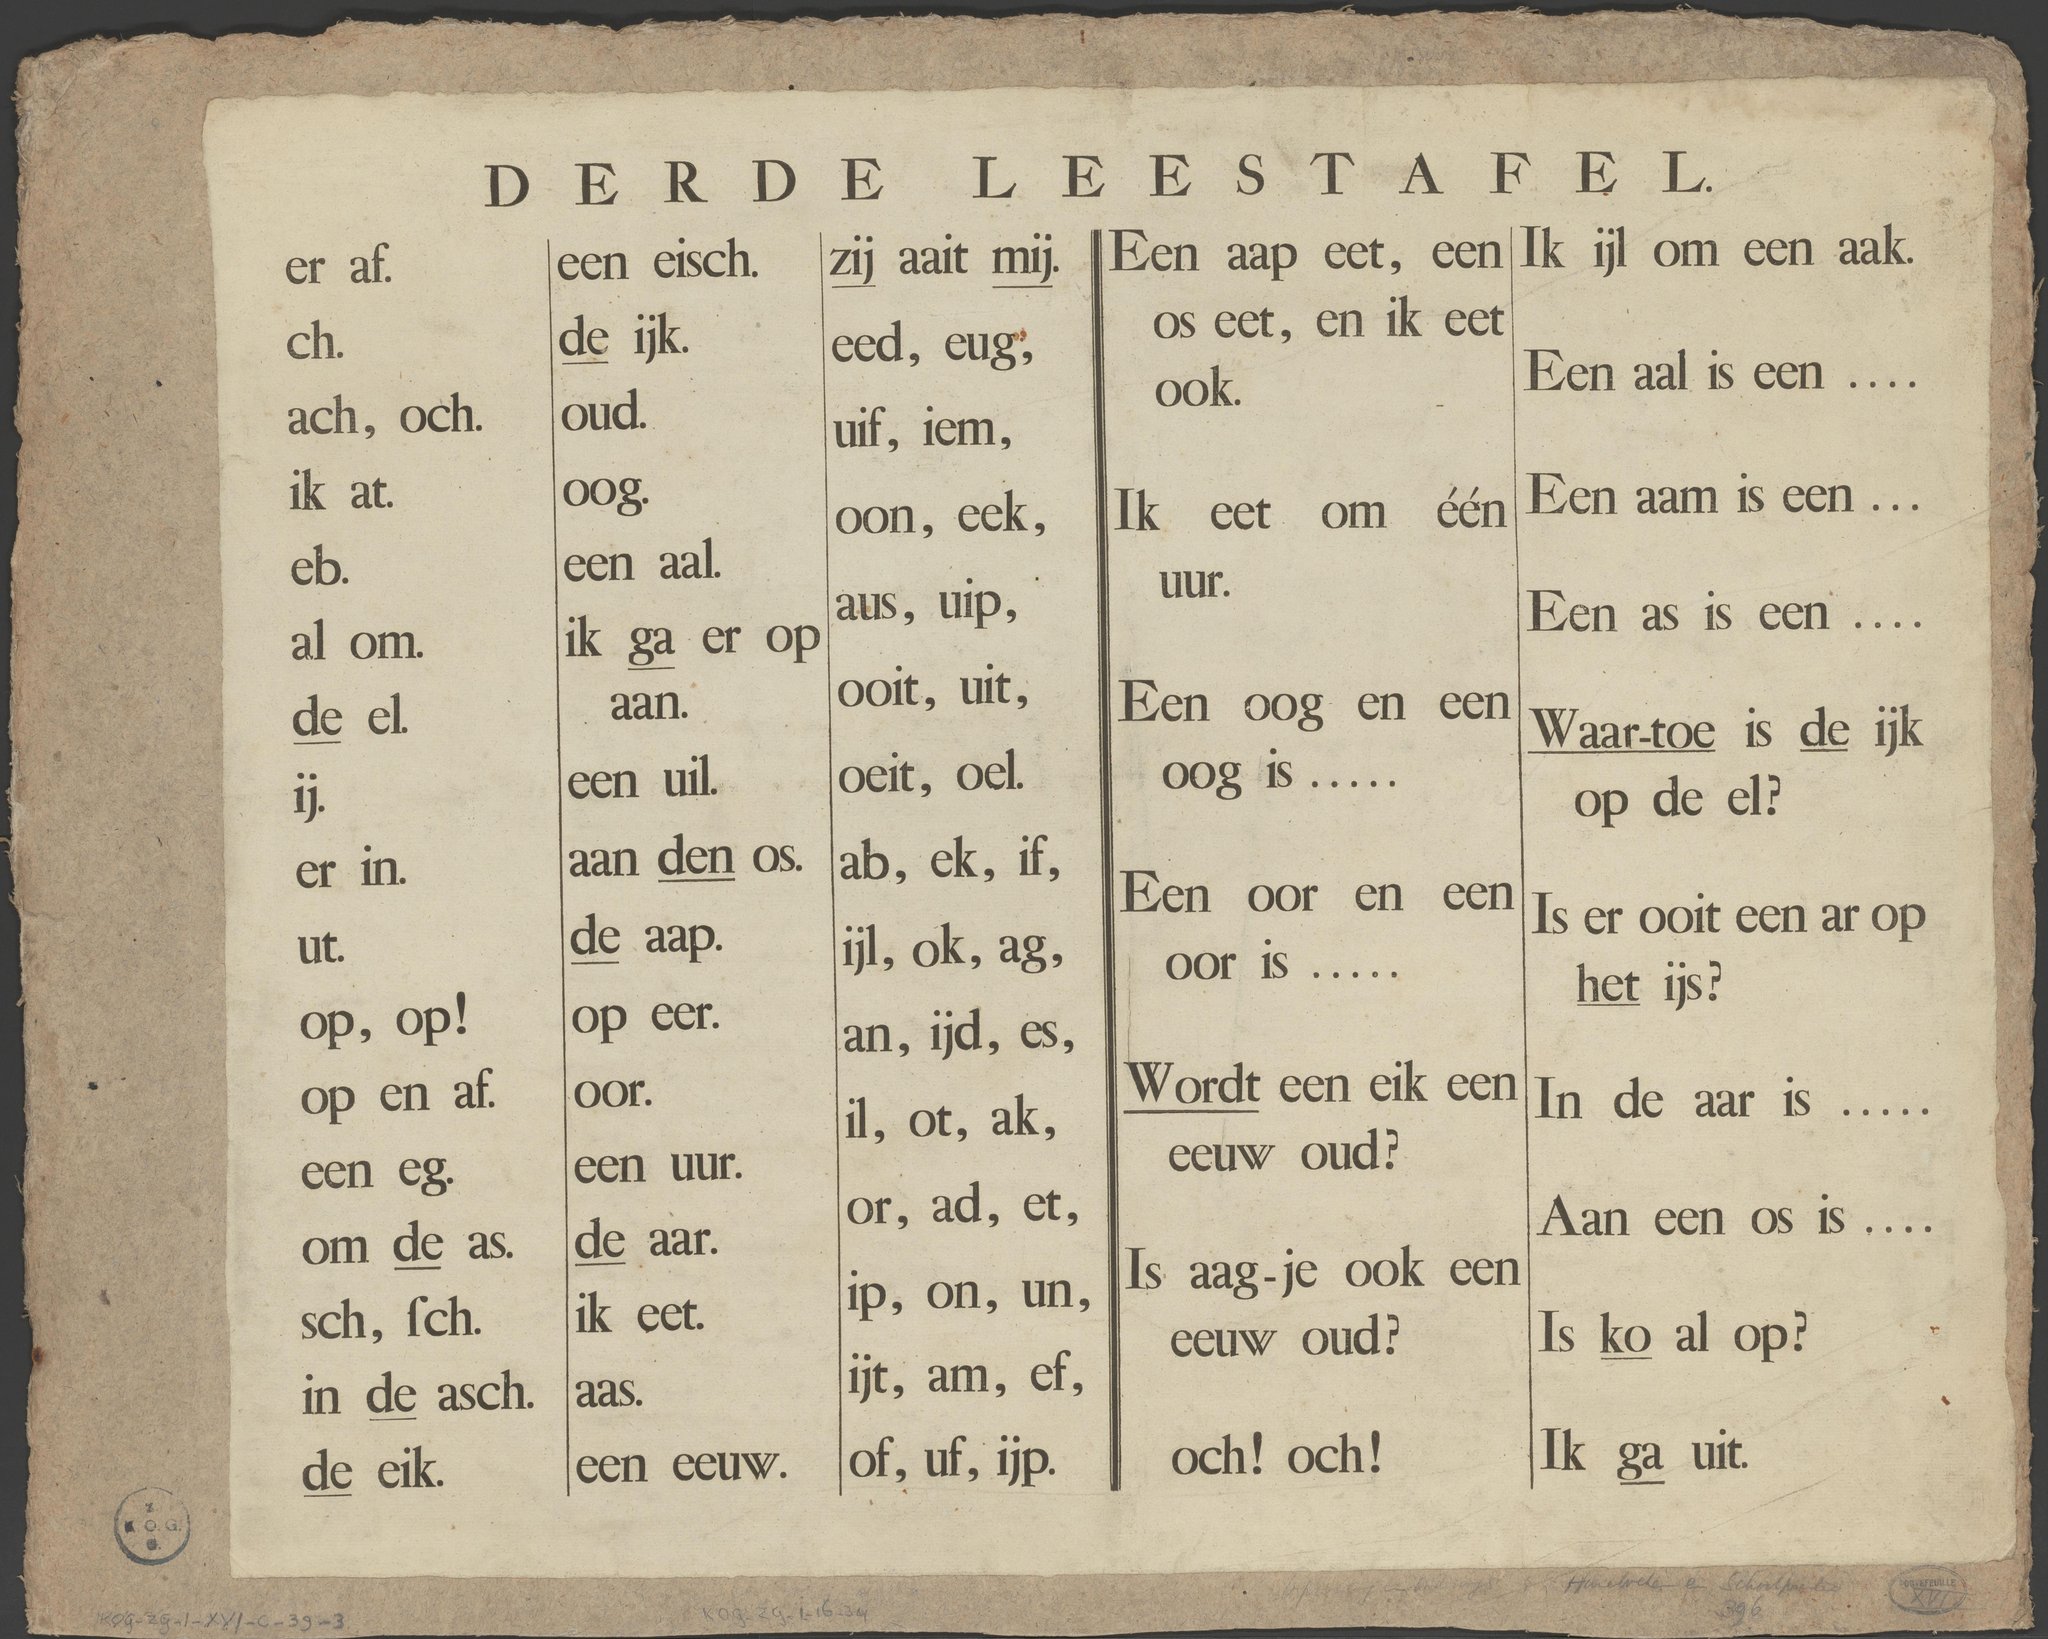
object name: text sheet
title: Derde leestafel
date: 1801-1849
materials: paper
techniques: letterpress printing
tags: linguistic communication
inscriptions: collector's mark: Lugt 1641, stamp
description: Leestafel met slotklanken in vijf kolommen. Onderwerpsrubrieken binnen de Atlas Zeden en Gewoonten: Onderwijs en Wetenschappen, Opvoeding en Onderwijs, Haneboeken en schoolprenten.